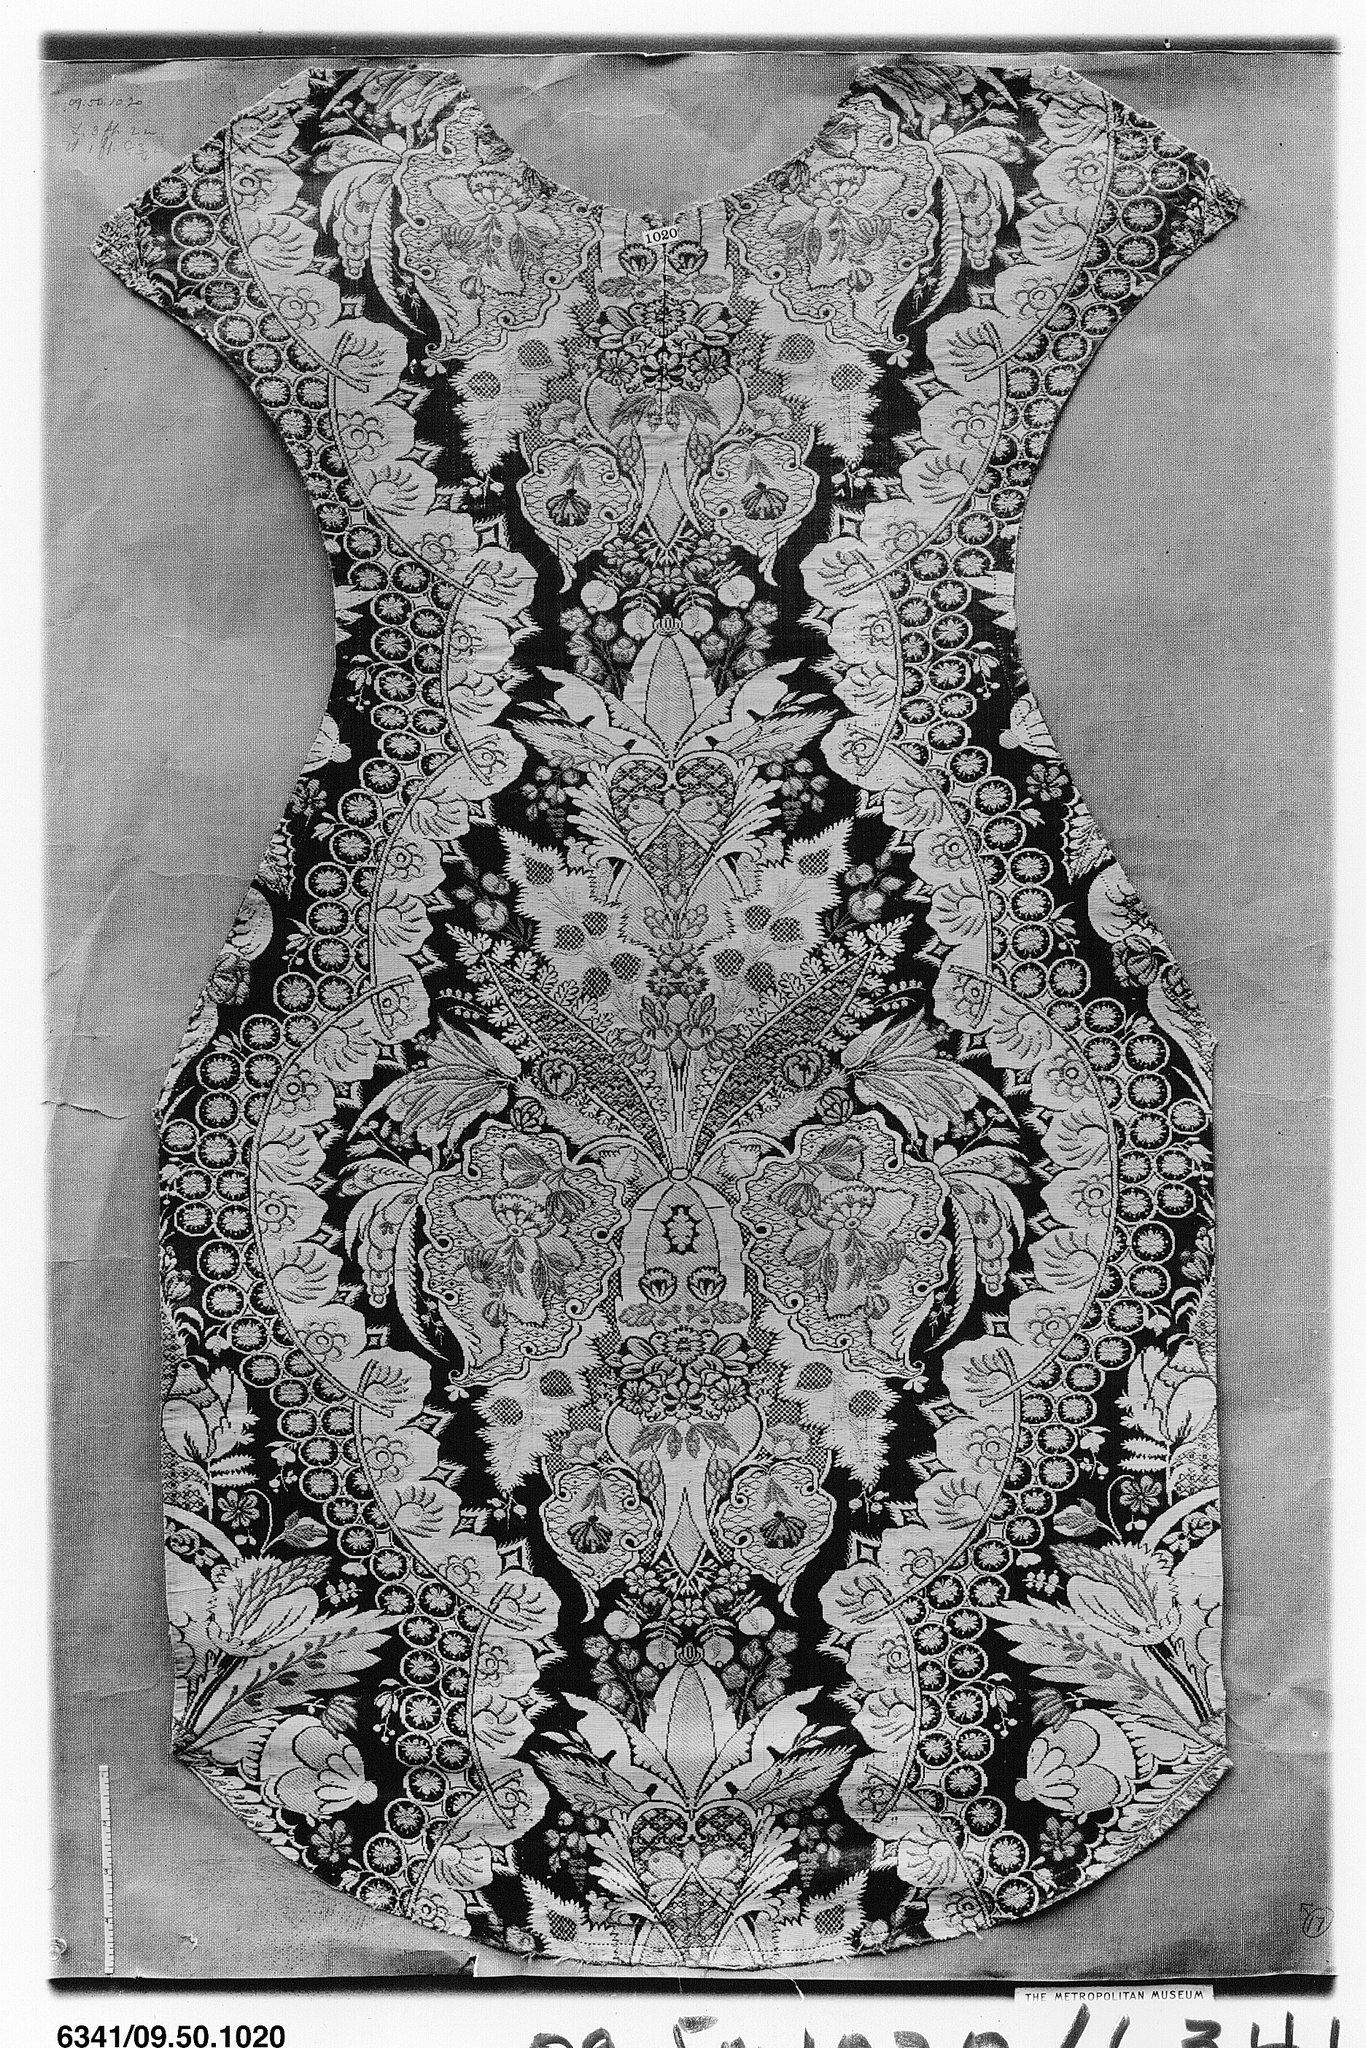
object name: piece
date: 1720-1725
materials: silk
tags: leaves